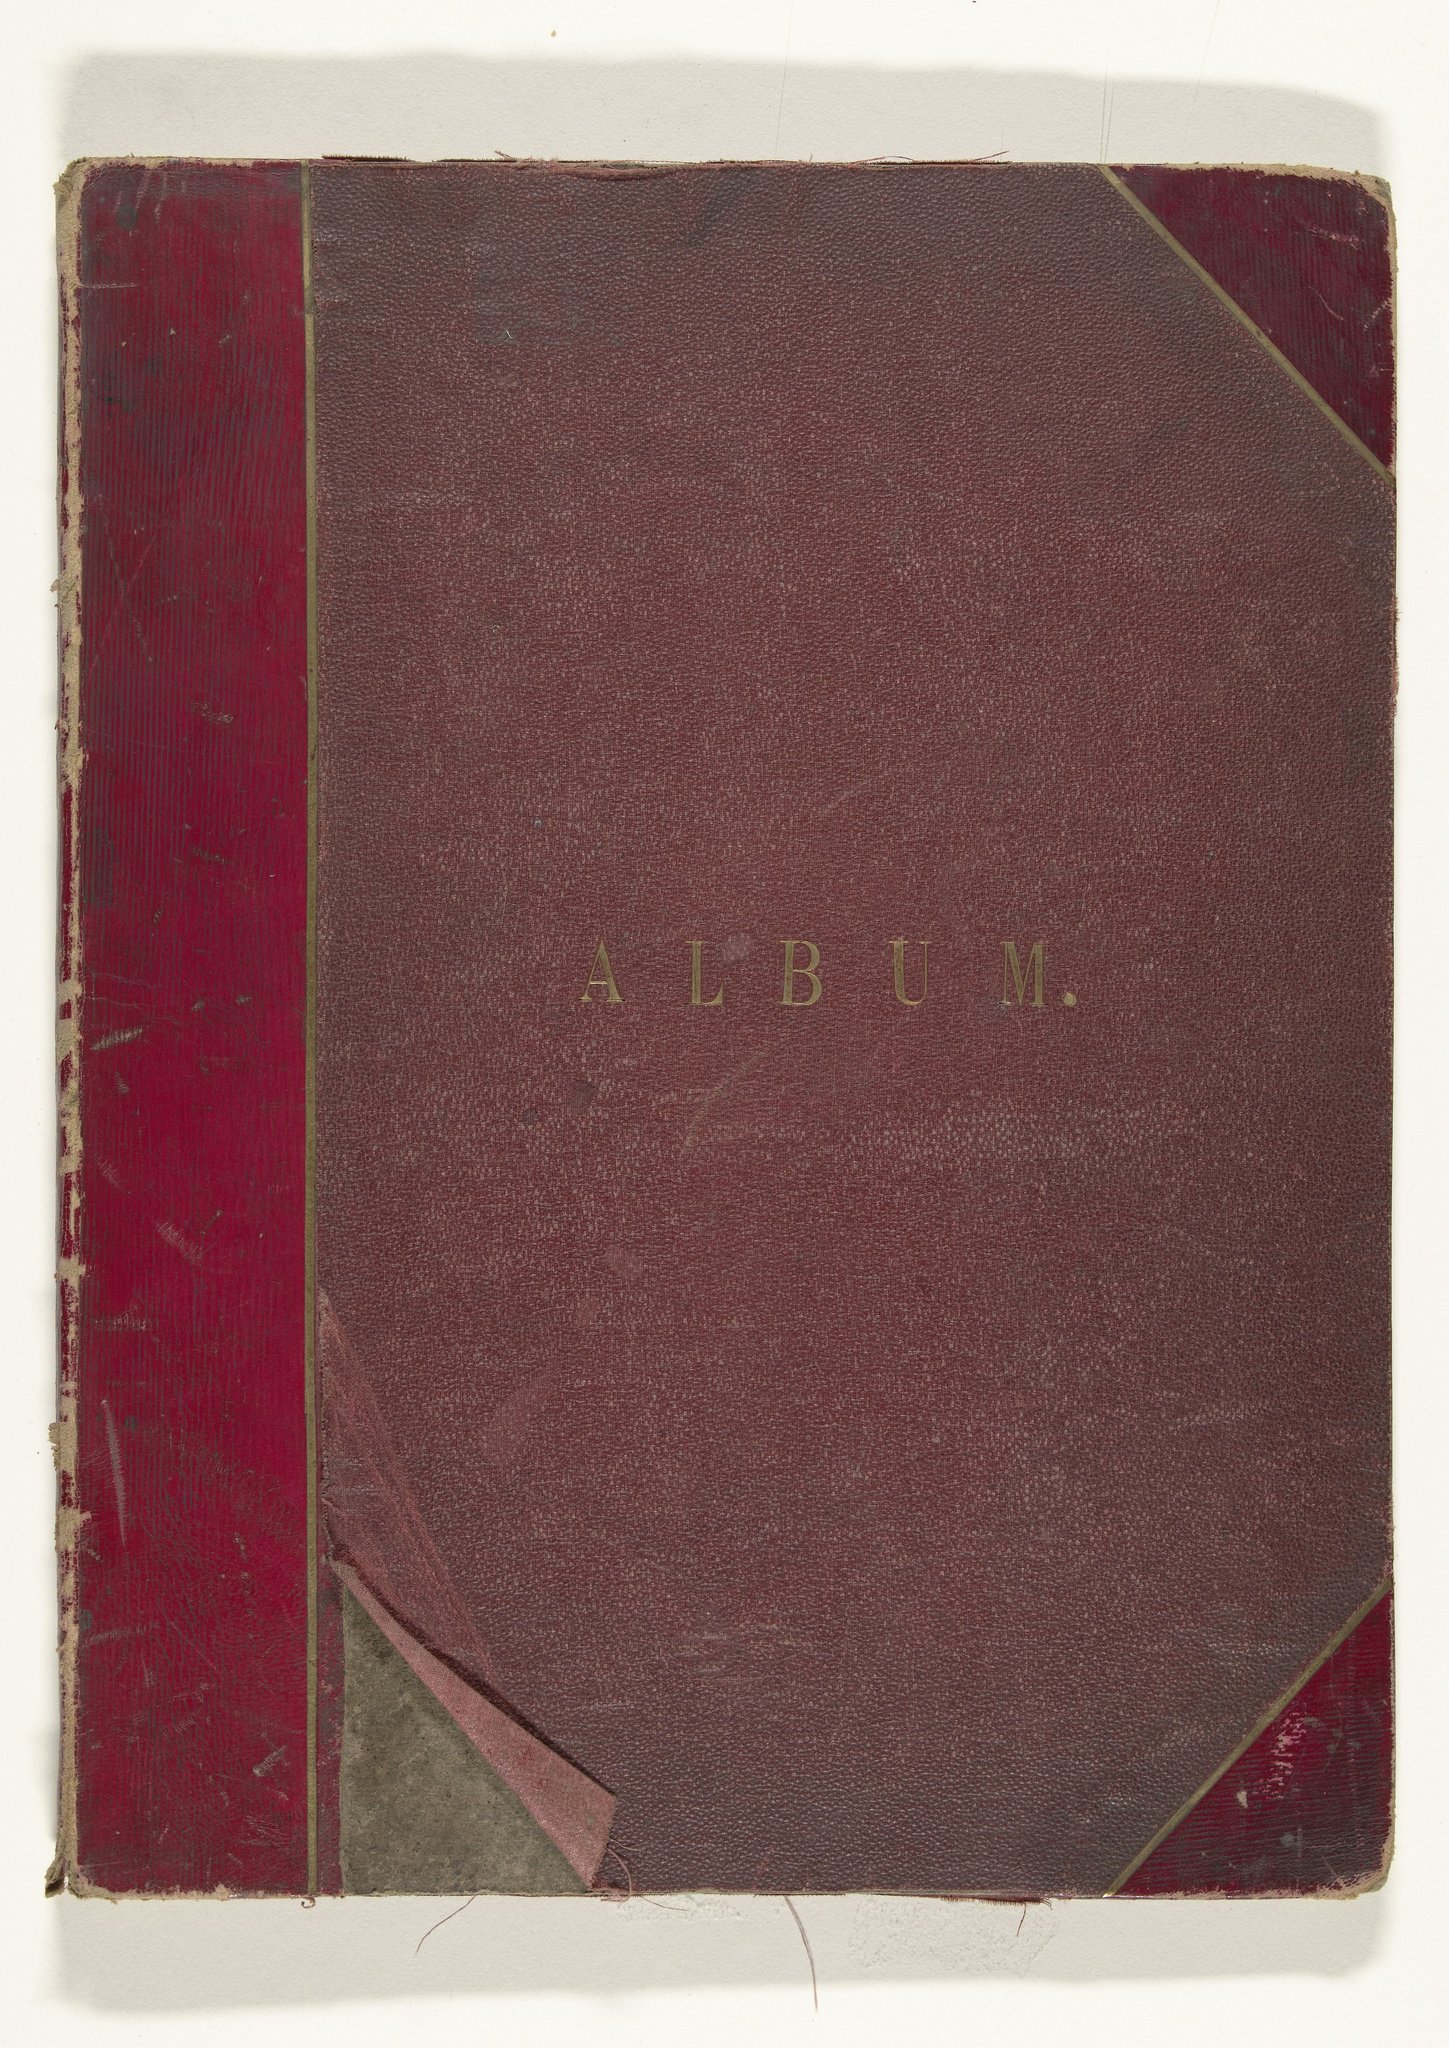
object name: scrapbook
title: Fotoalbum van de Britse gemeenschap in China, voornamelijk in Xiamen en Fuzhou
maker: Anonymous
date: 1876-1890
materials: cardboard, leather, linen, paper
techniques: albumen print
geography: china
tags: city-view in general; 'veduta', control, investigation ~ customs, coast, china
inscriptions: inscription: ‘Collection of Rice Paper Drawings (Removed '82)/ & Photographs of China’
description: Album met 79 albuminedrukken van de Britse gemeenschap in China. Enkele foto's bevatten handgeschreven bijschriften. Het album komt vermoedelijk uit de omgeving van medewerker van de douane, een vriend of collega van J. Lloyd E. Palm. Van vrijwel alle foto's is de fotograaf anoniem. Vermoedelijk handelt het hier om een amateur, die tevens de samensteller van het album is.